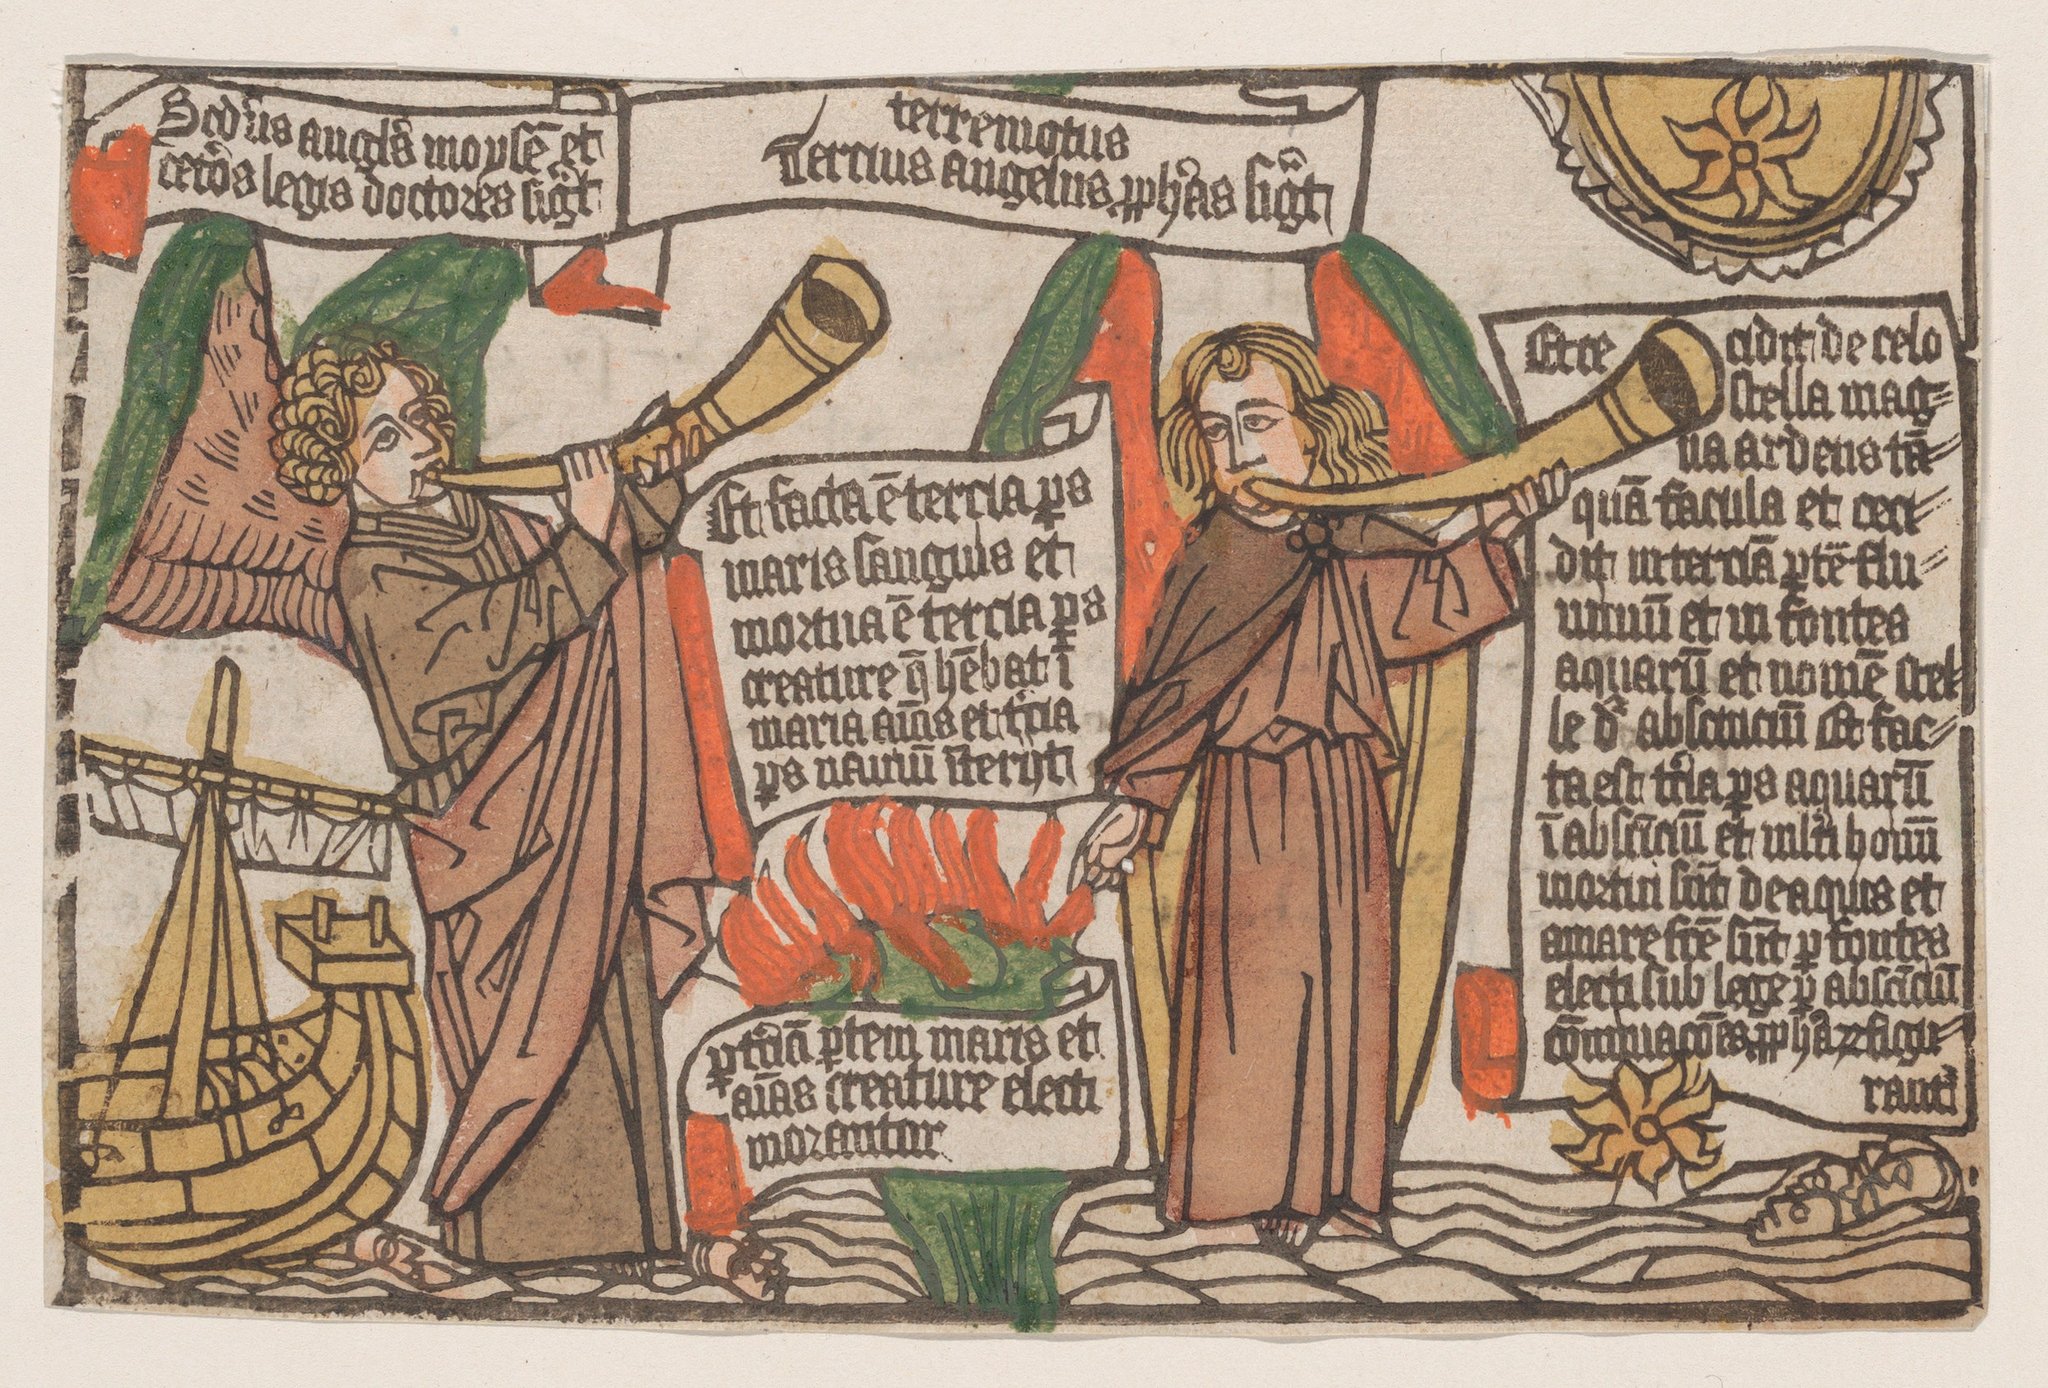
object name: print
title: The Mountain and the Star Fall into the Sea, from the "Apocalypsis Sancti Johannis" block book, fourth edition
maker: anonymous, german, 15th century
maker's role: artist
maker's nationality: german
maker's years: 1400-1500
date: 1460-1470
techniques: hand coloring, woodcut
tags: men,horns